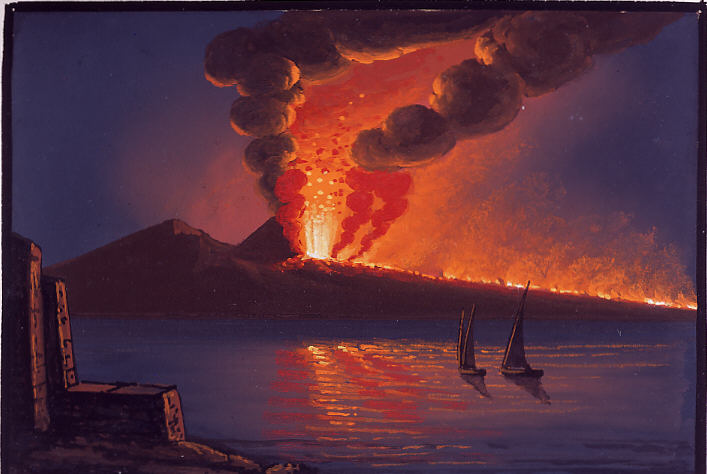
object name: sketchbook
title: Sketchbook: Souvenir of Naples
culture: italian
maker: Anonymous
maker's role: artist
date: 1821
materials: gouache, graphite, watercolor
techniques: bookbinding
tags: cities